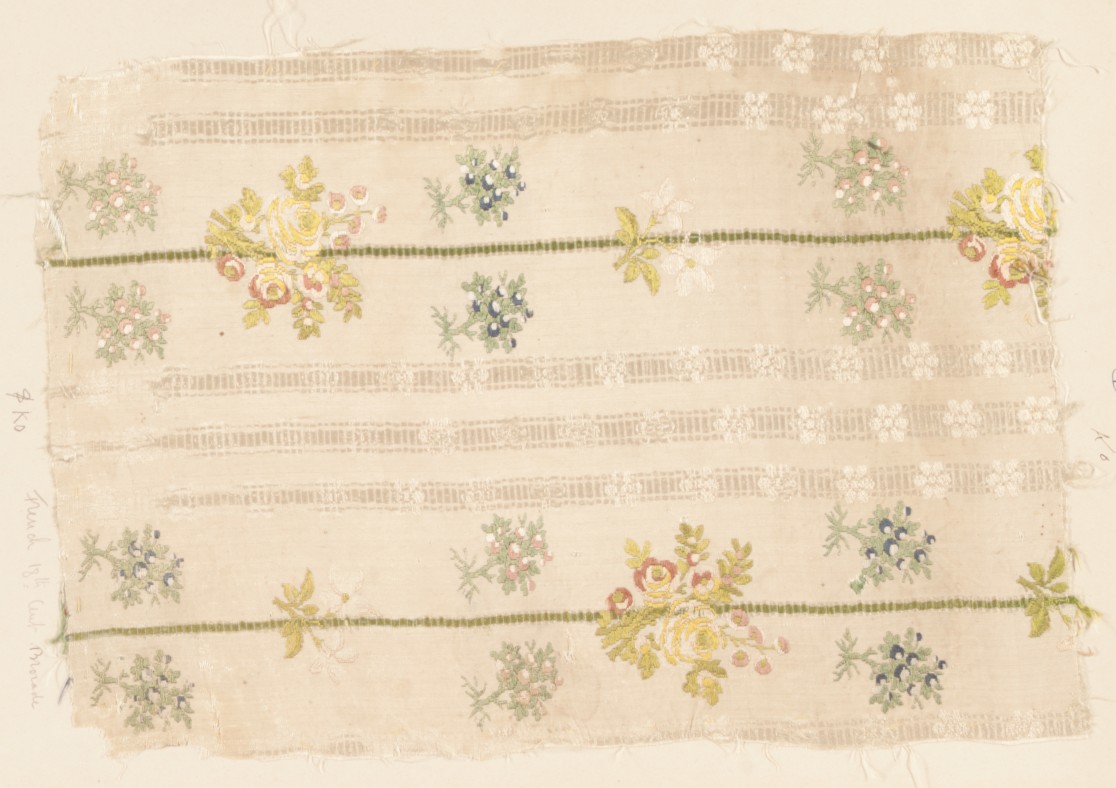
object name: fragment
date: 1701-1800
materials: silk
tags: flowers